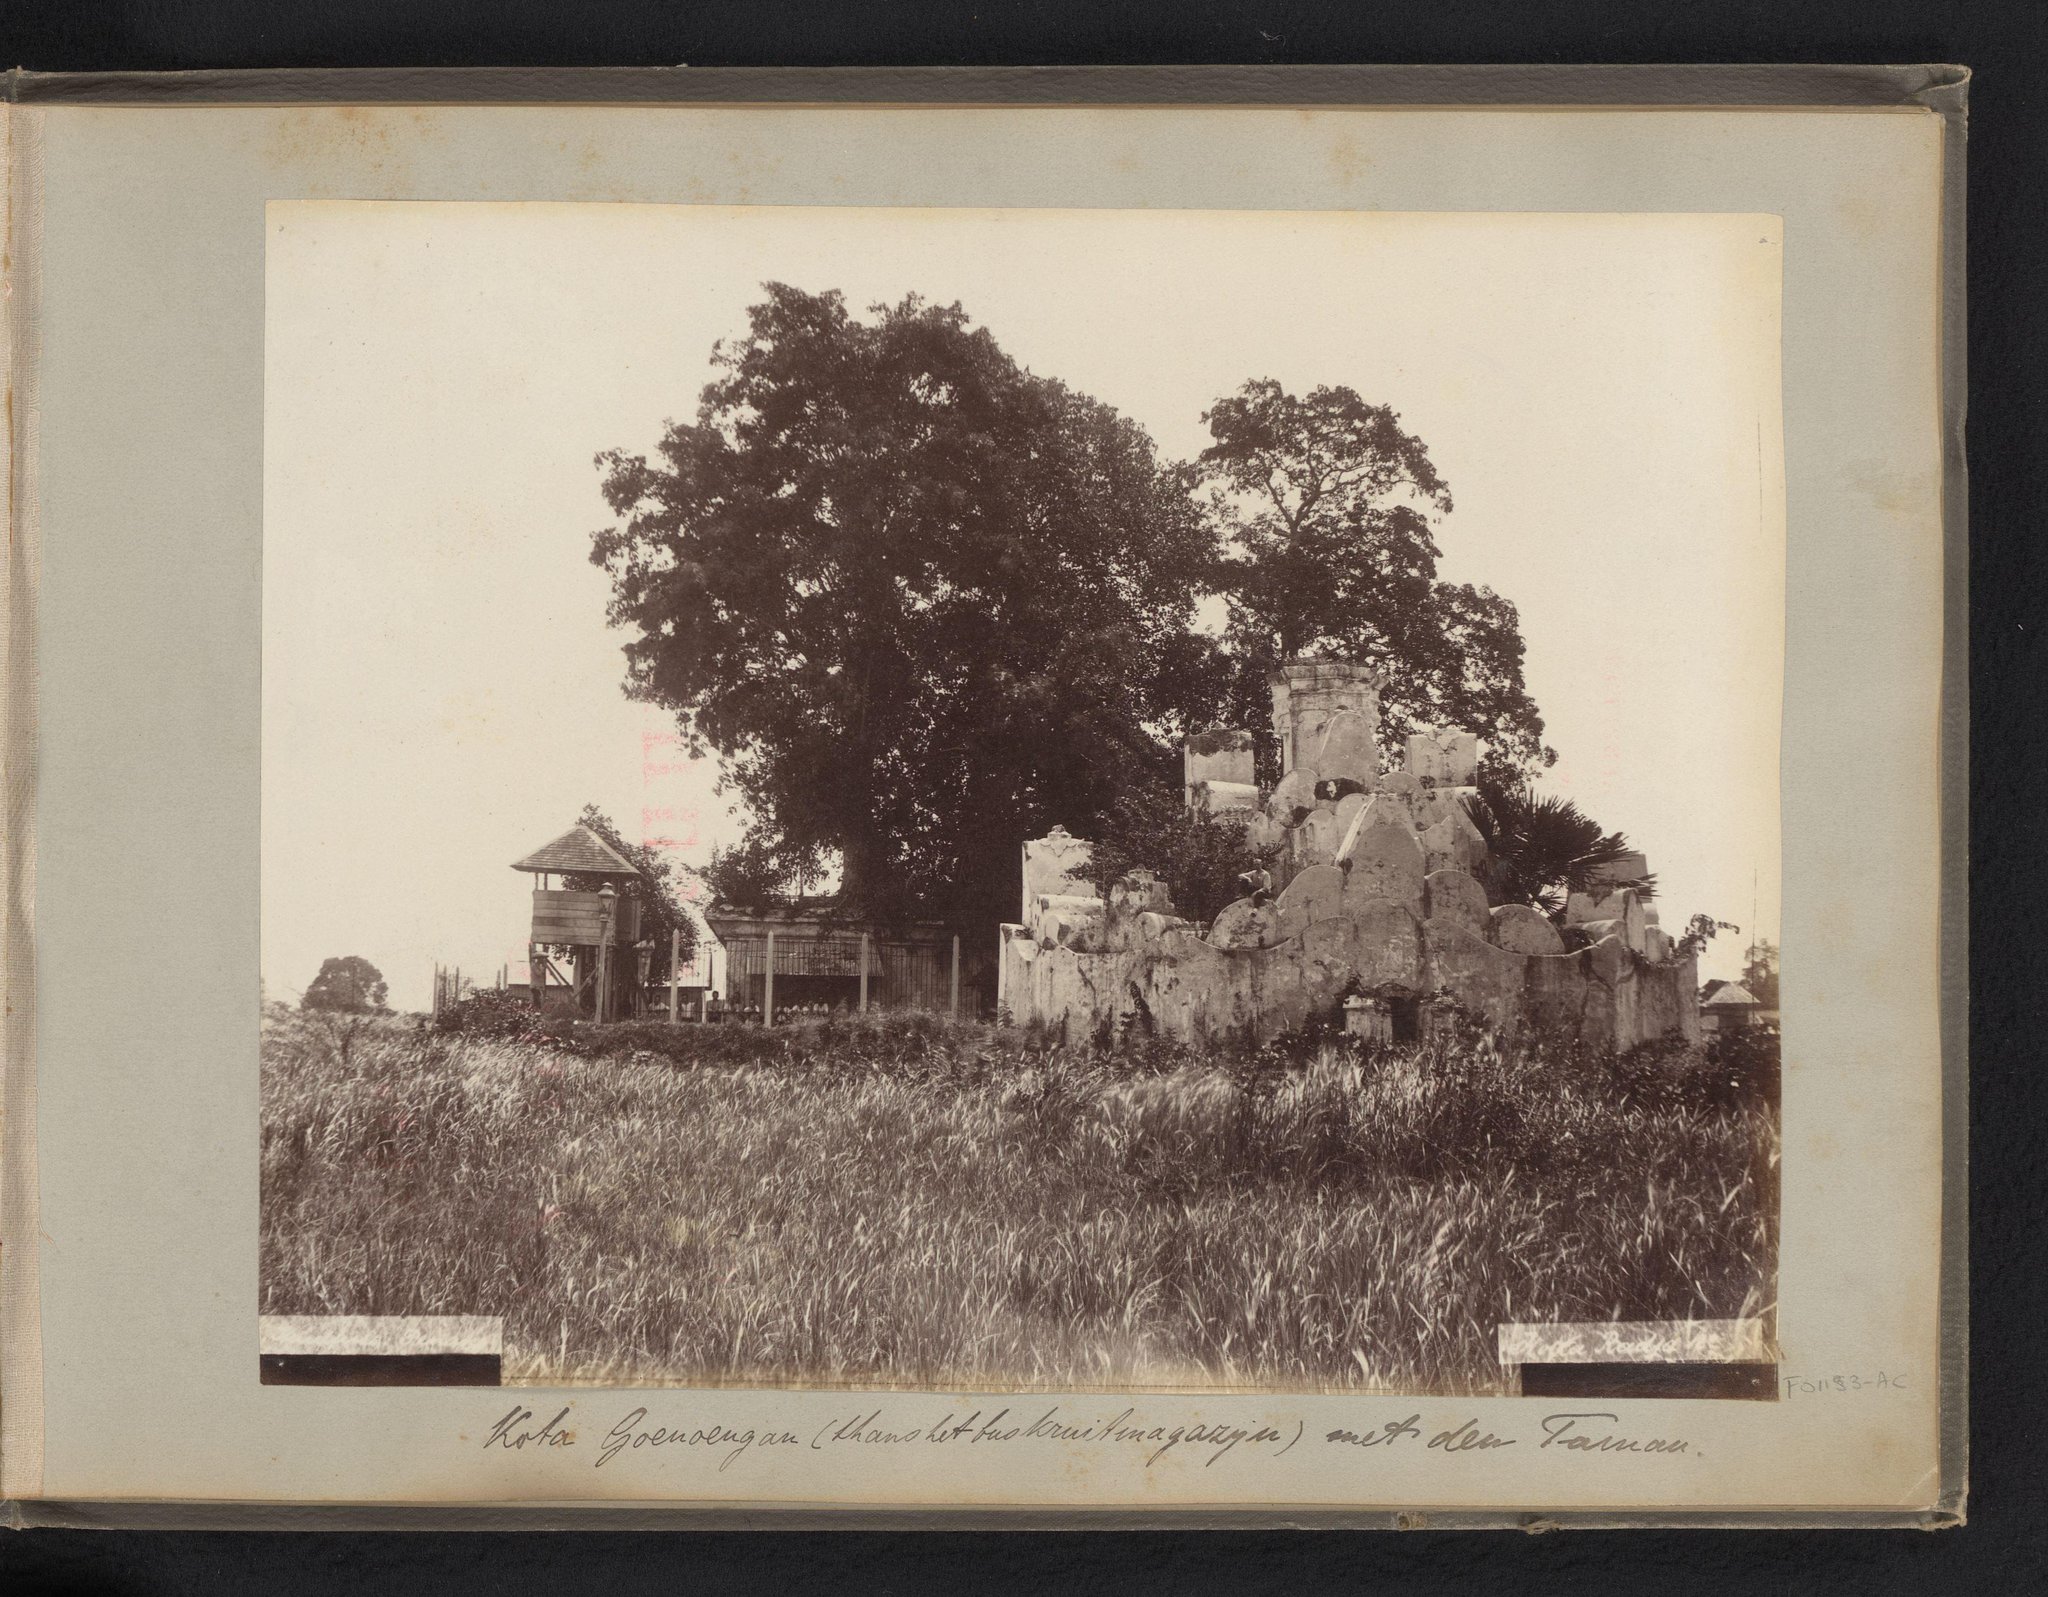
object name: album leaf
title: Kota Goenoengan (thans het buskruitmagazijn) met den Tarman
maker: a. kaulfuss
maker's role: fotograaf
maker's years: 1861-1909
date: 1891-1894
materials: photographic support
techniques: albumen print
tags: prison, jail